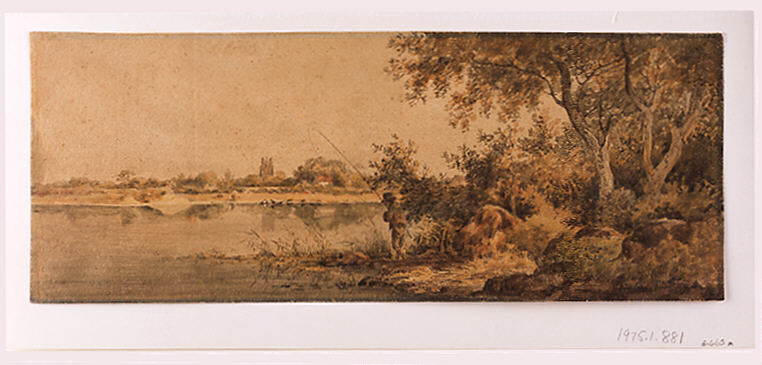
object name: drawing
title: Landscape with Boy Fishing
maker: john crome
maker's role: artist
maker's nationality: british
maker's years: 1768-1821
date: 1818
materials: graphite, paper, watercolor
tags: boys,fishing,landscapes